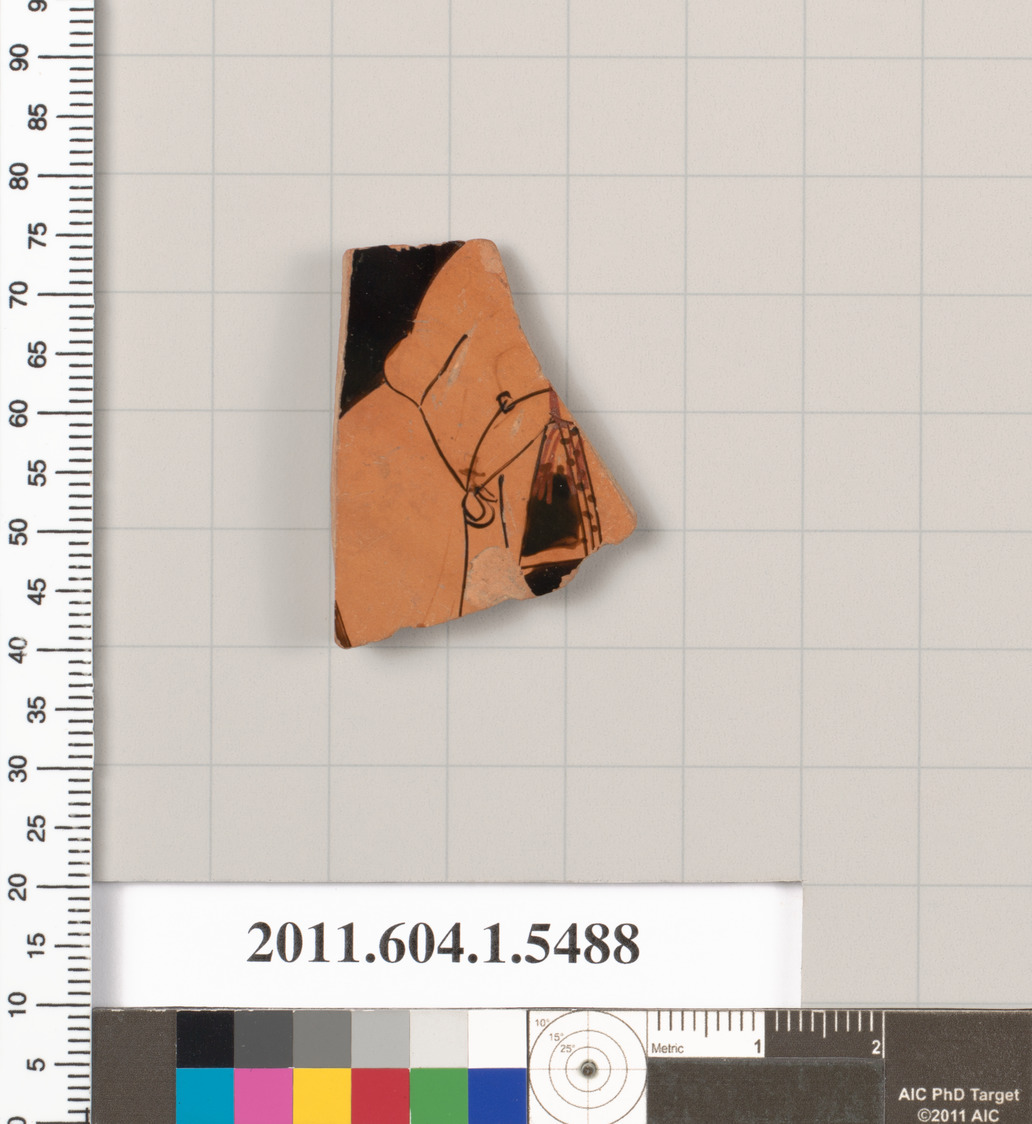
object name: kylix fragment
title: Terracotta fragment of a kylix (drinking cup)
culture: greek, attic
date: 490-480 BCE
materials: terracotta